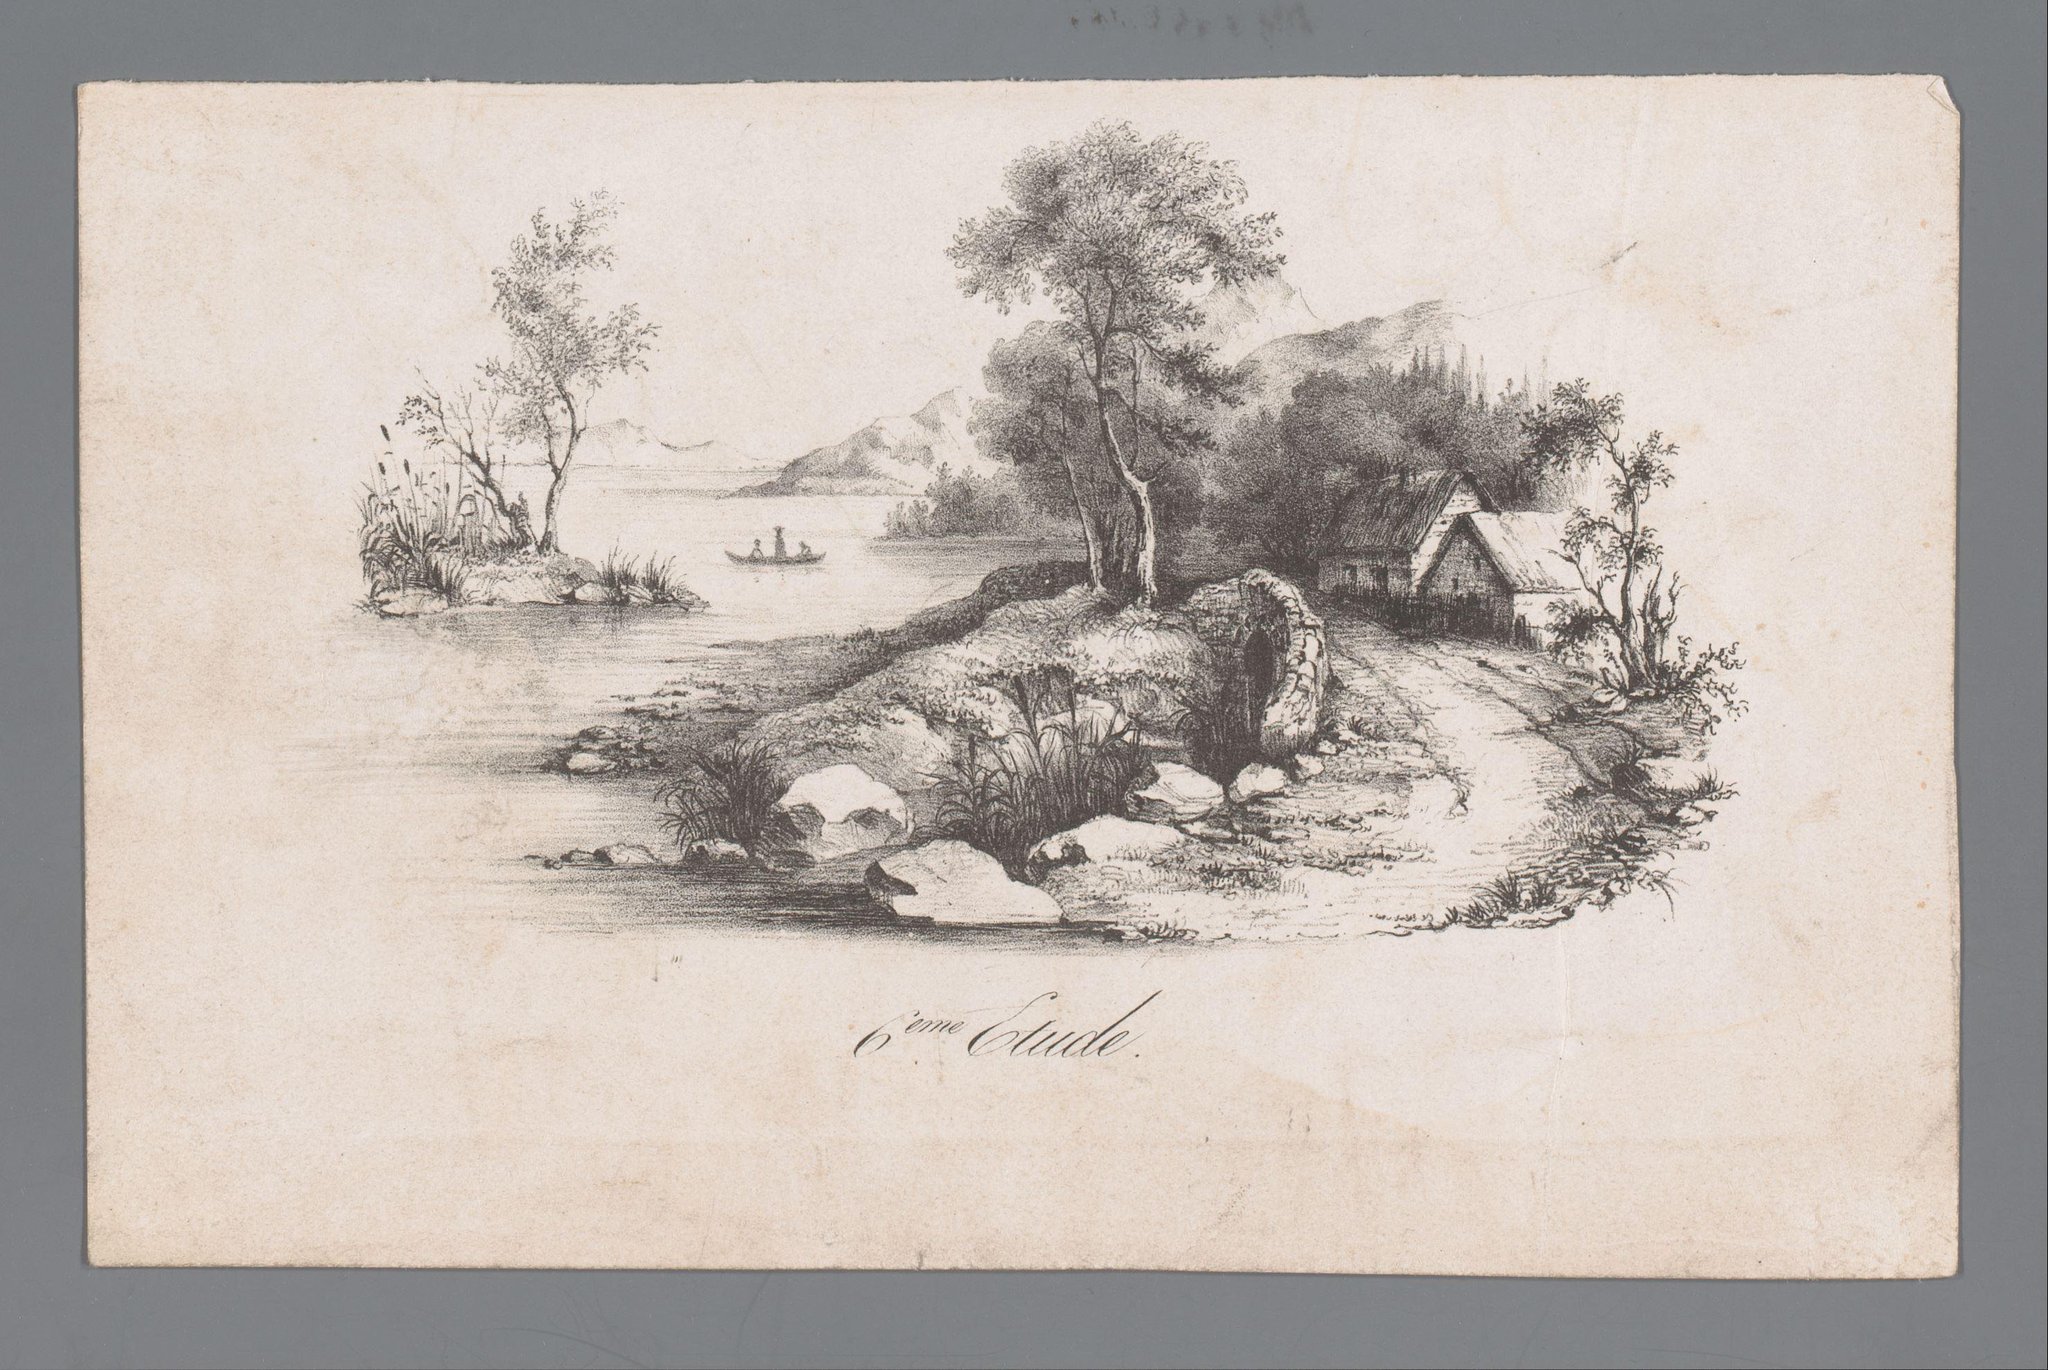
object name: print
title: 6eme Etude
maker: paulus lauters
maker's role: print maker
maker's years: 1806-1875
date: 1816-1875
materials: paper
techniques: lithograph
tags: river, hut, cabin, lodge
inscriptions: collector's mark: Lugt 2228